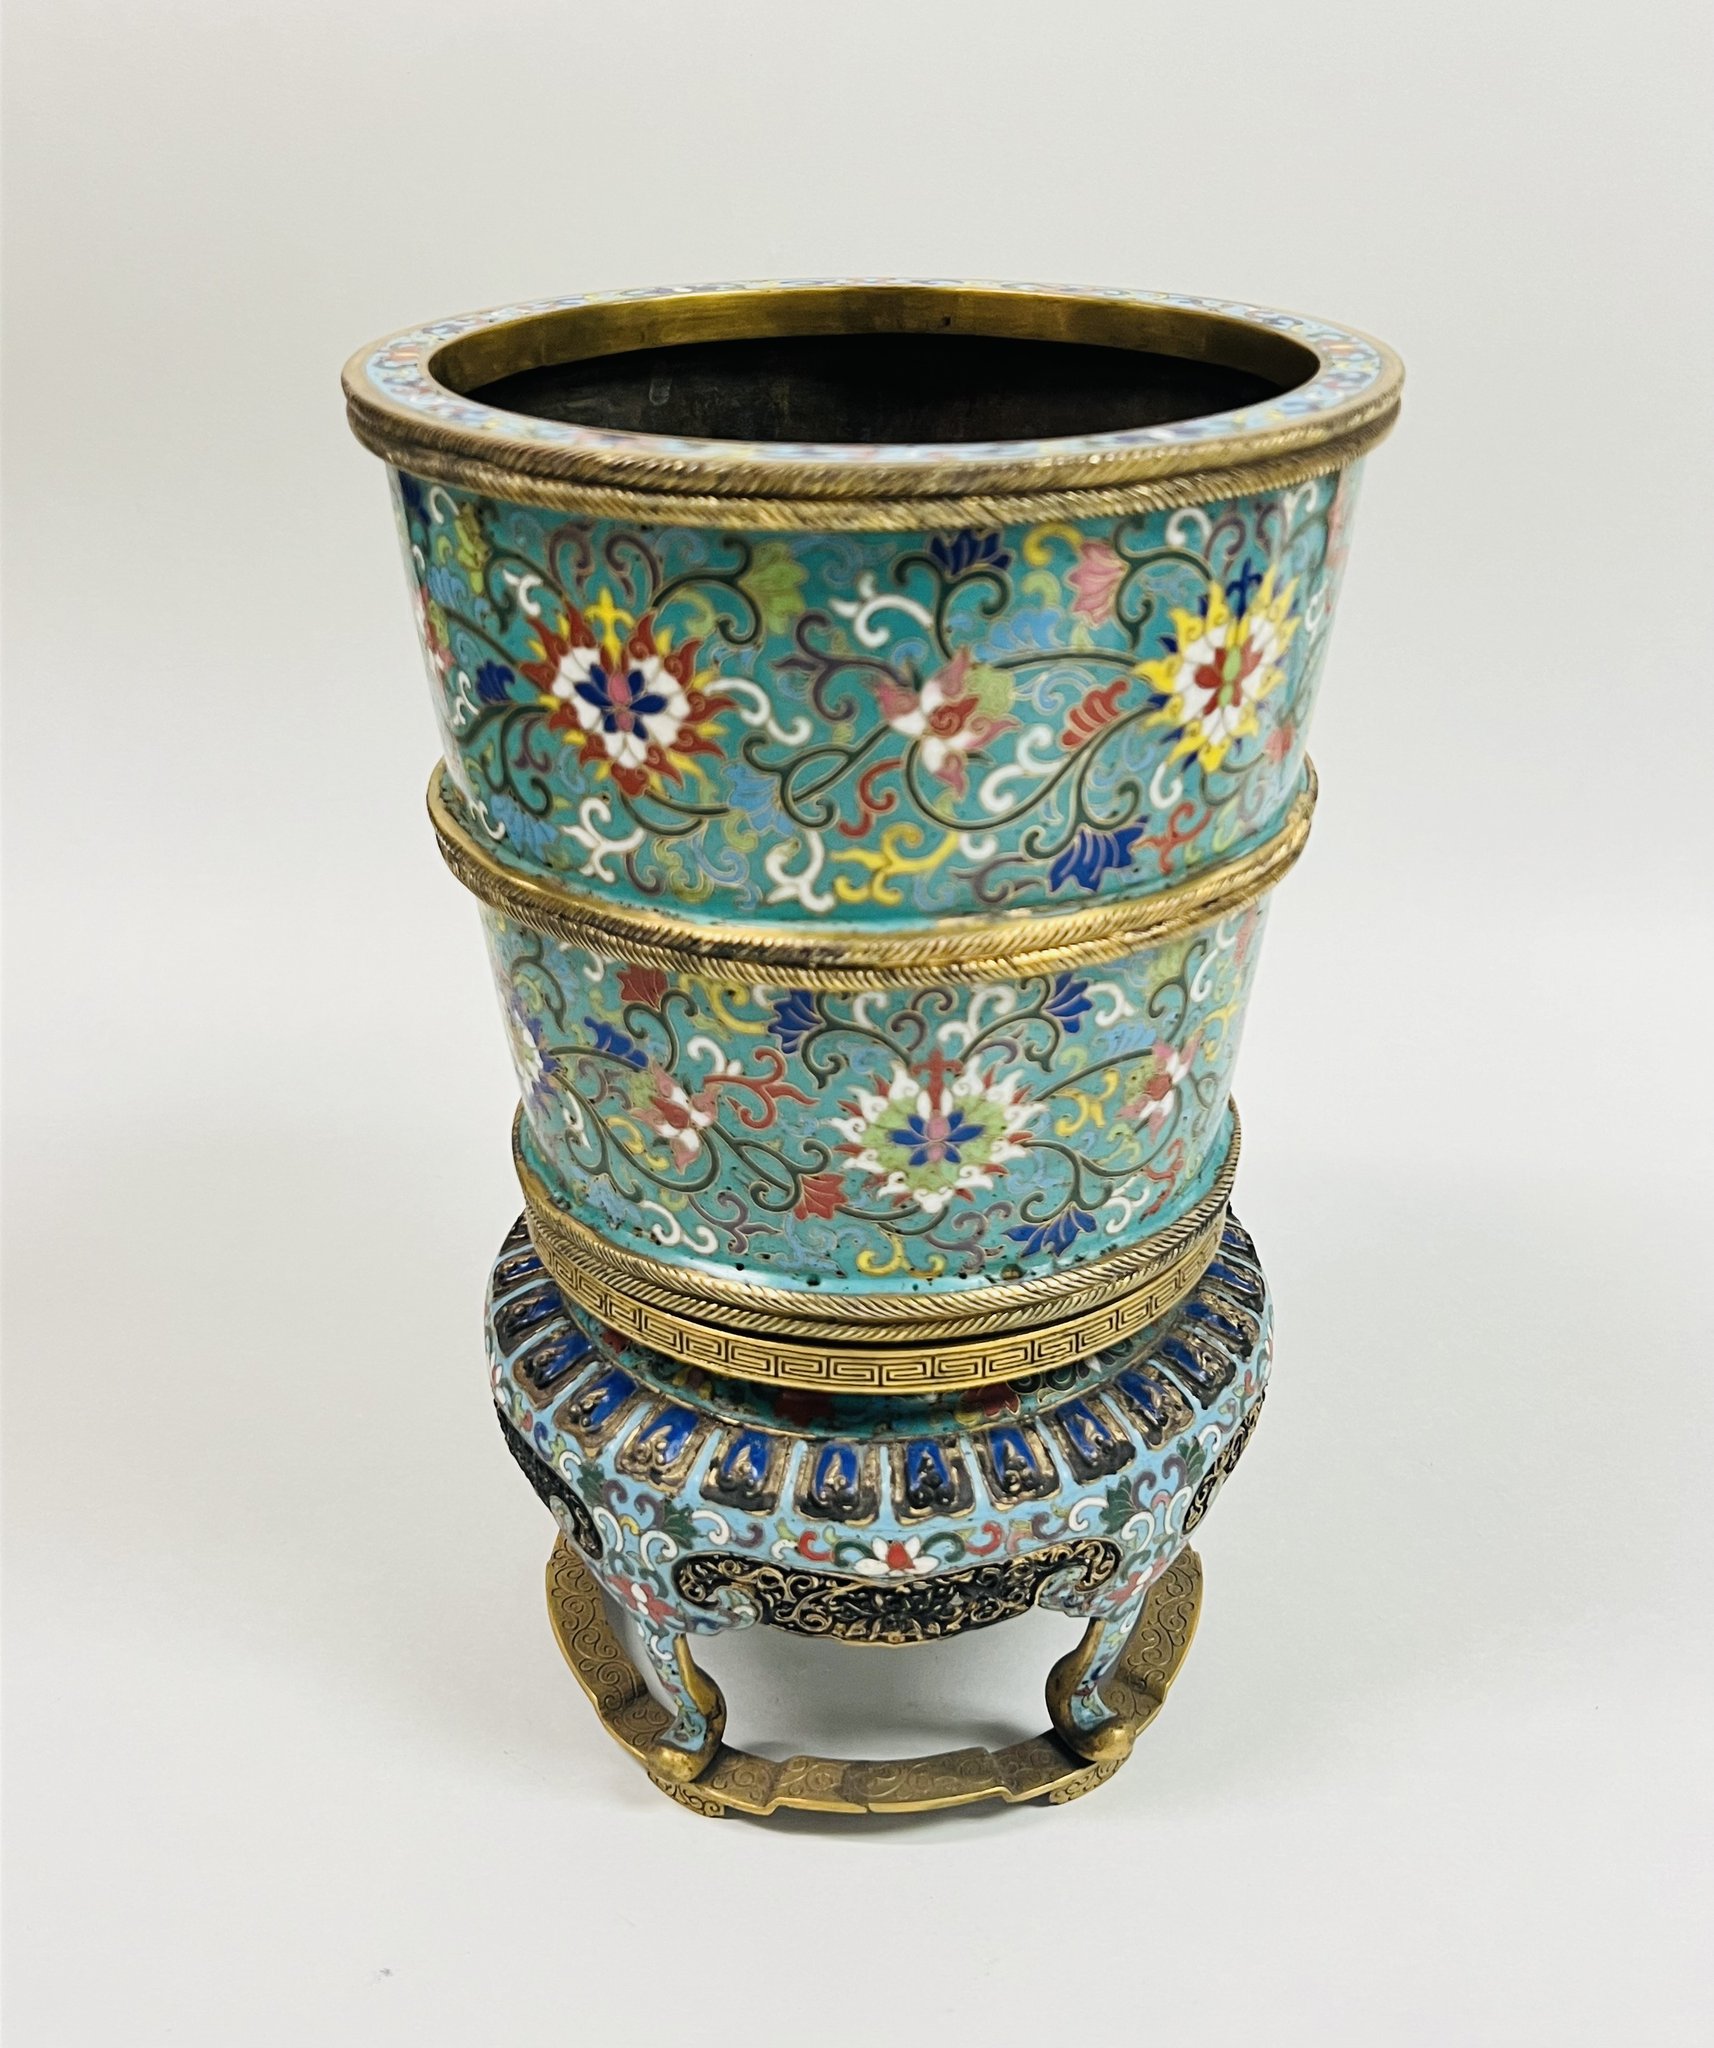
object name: flower pot with stand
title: Flower Pot with Stand (One of a Pair)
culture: chinese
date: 1736-1795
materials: enamel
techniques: enamel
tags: flowers